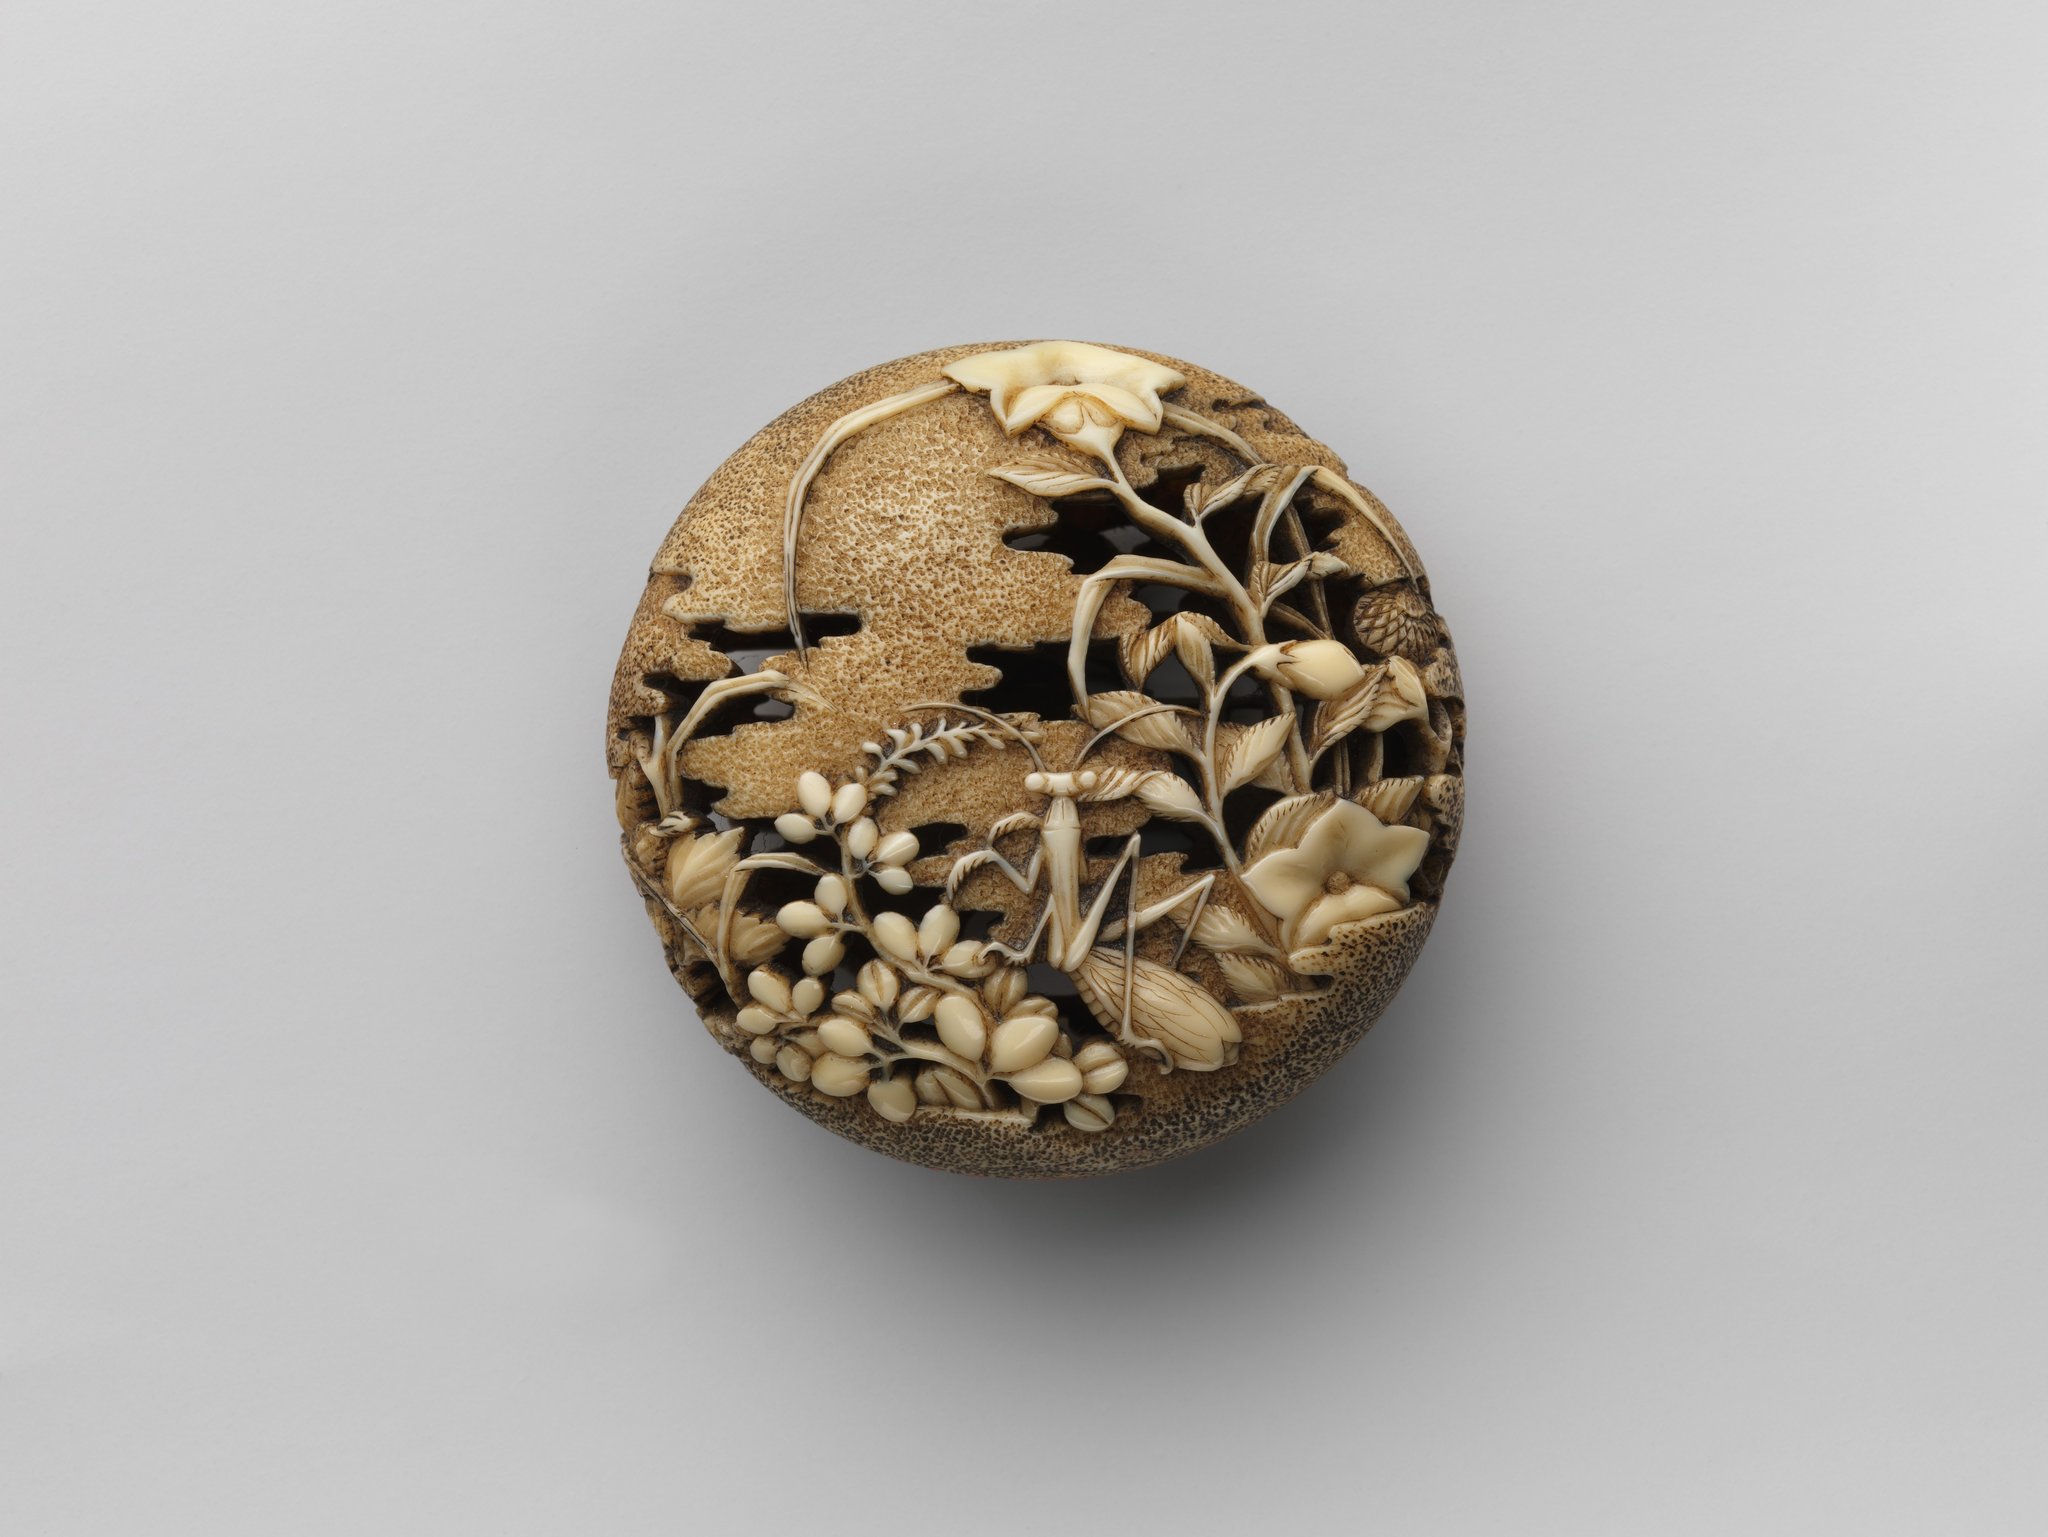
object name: netsuke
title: Flowers and Grasses with a Praying-Mantis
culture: japanese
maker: ryūsa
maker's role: artist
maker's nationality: japanese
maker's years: 1767-1799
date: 1767-1800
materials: ivory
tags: insects,flowers